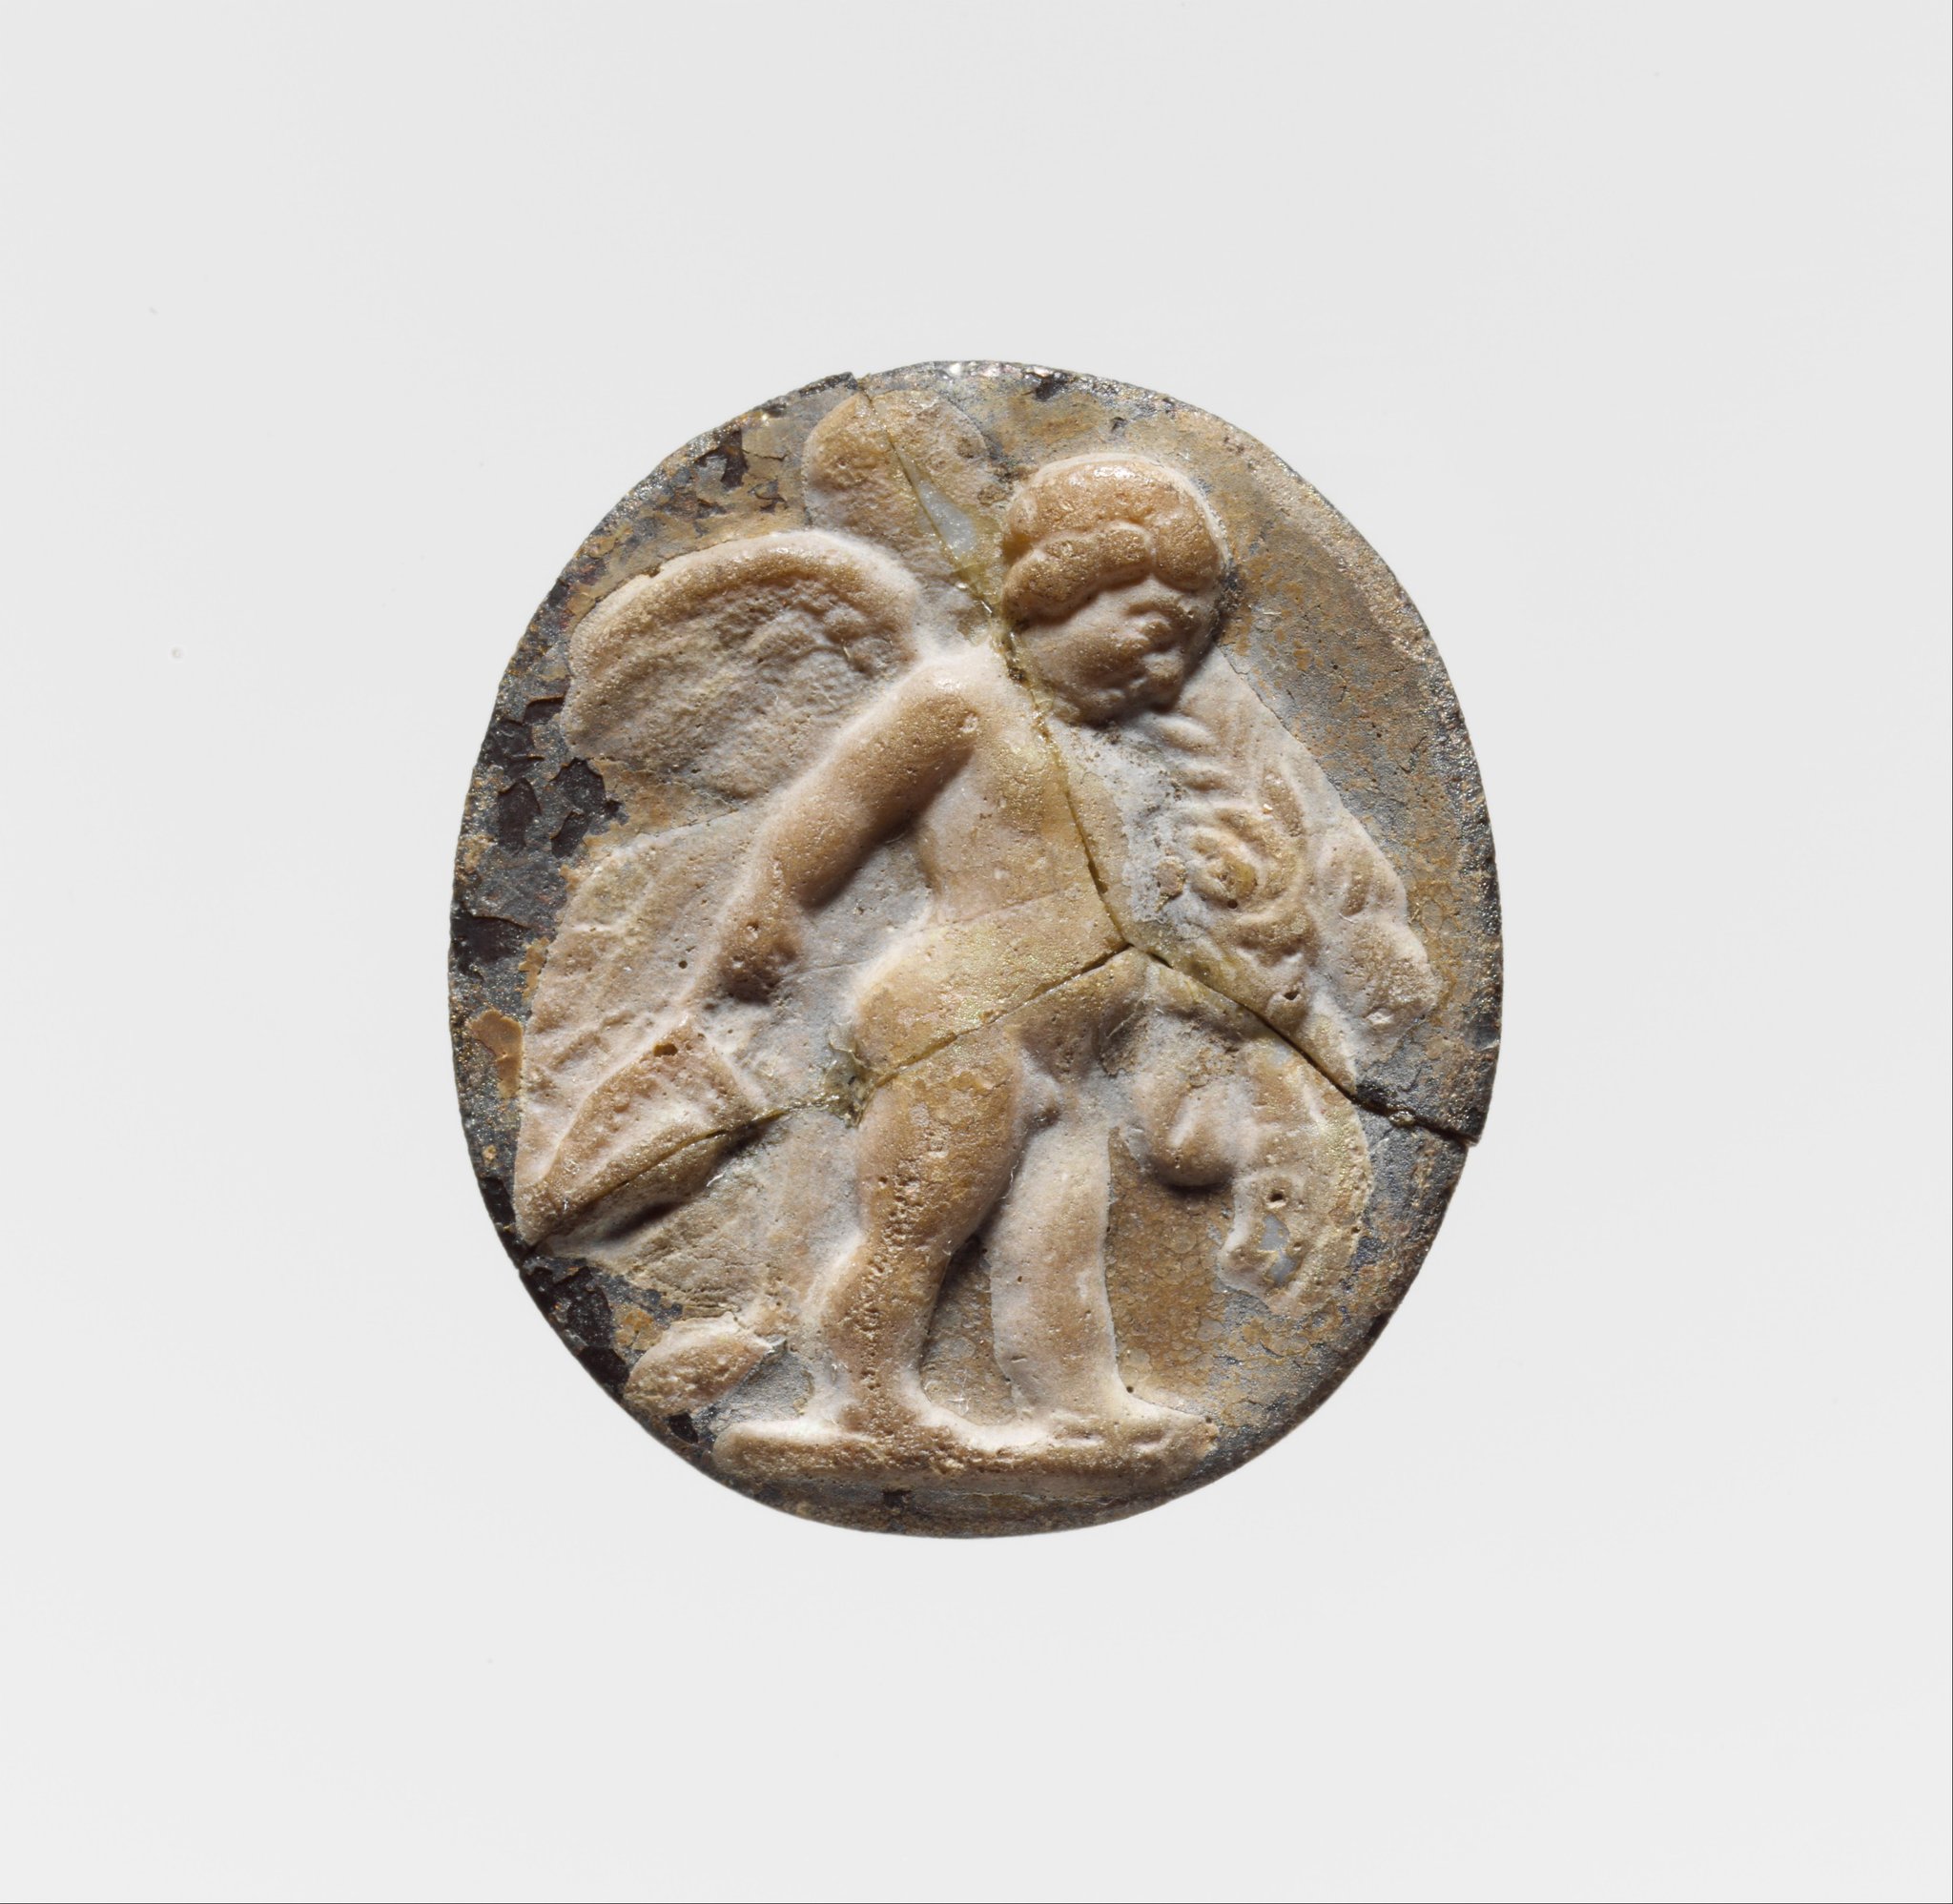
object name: cameo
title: Glass cameo: winged Eros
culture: roman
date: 34 BCE-33 CE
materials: glass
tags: eros